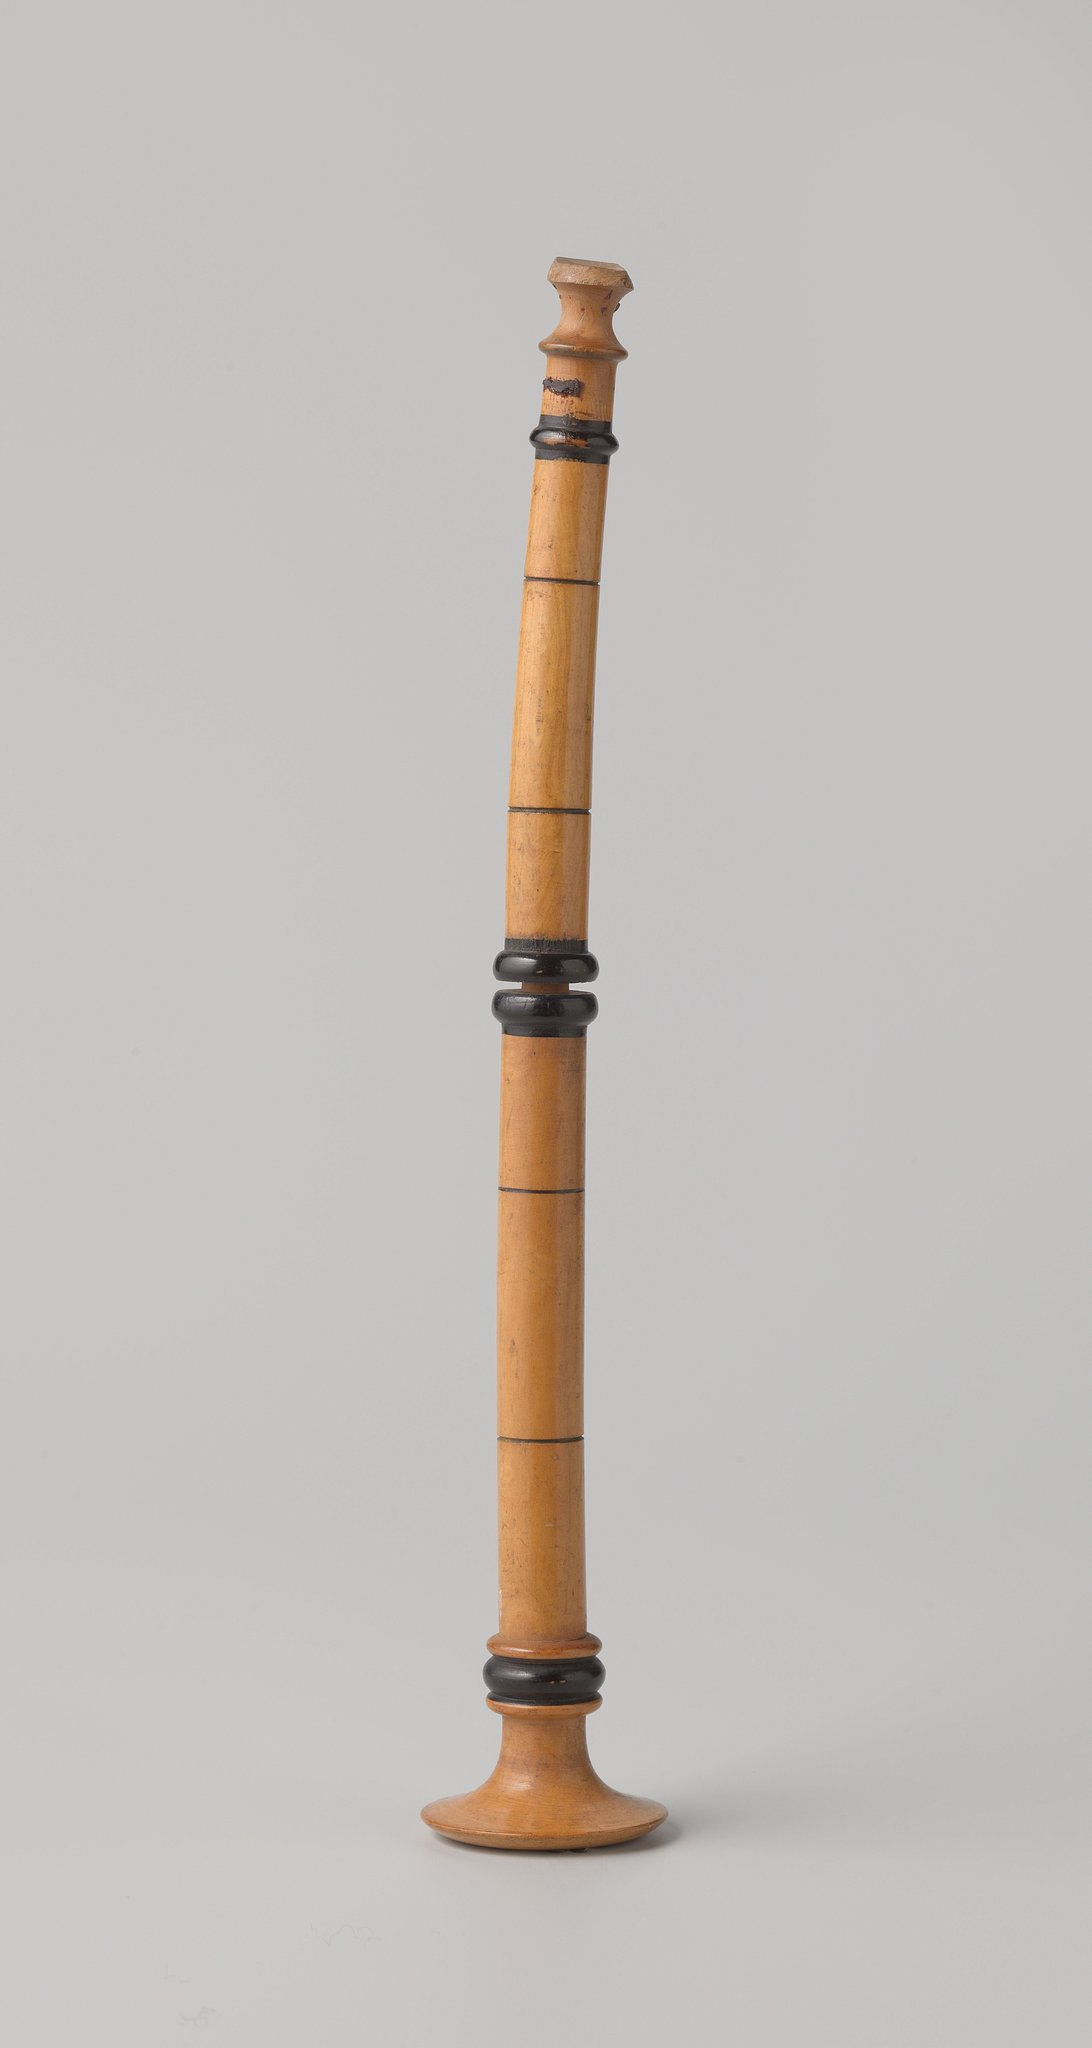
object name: bagpipe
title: Bagpipe chanter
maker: Anonymous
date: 1850-1896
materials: wood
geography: england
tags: bagpipe, musette